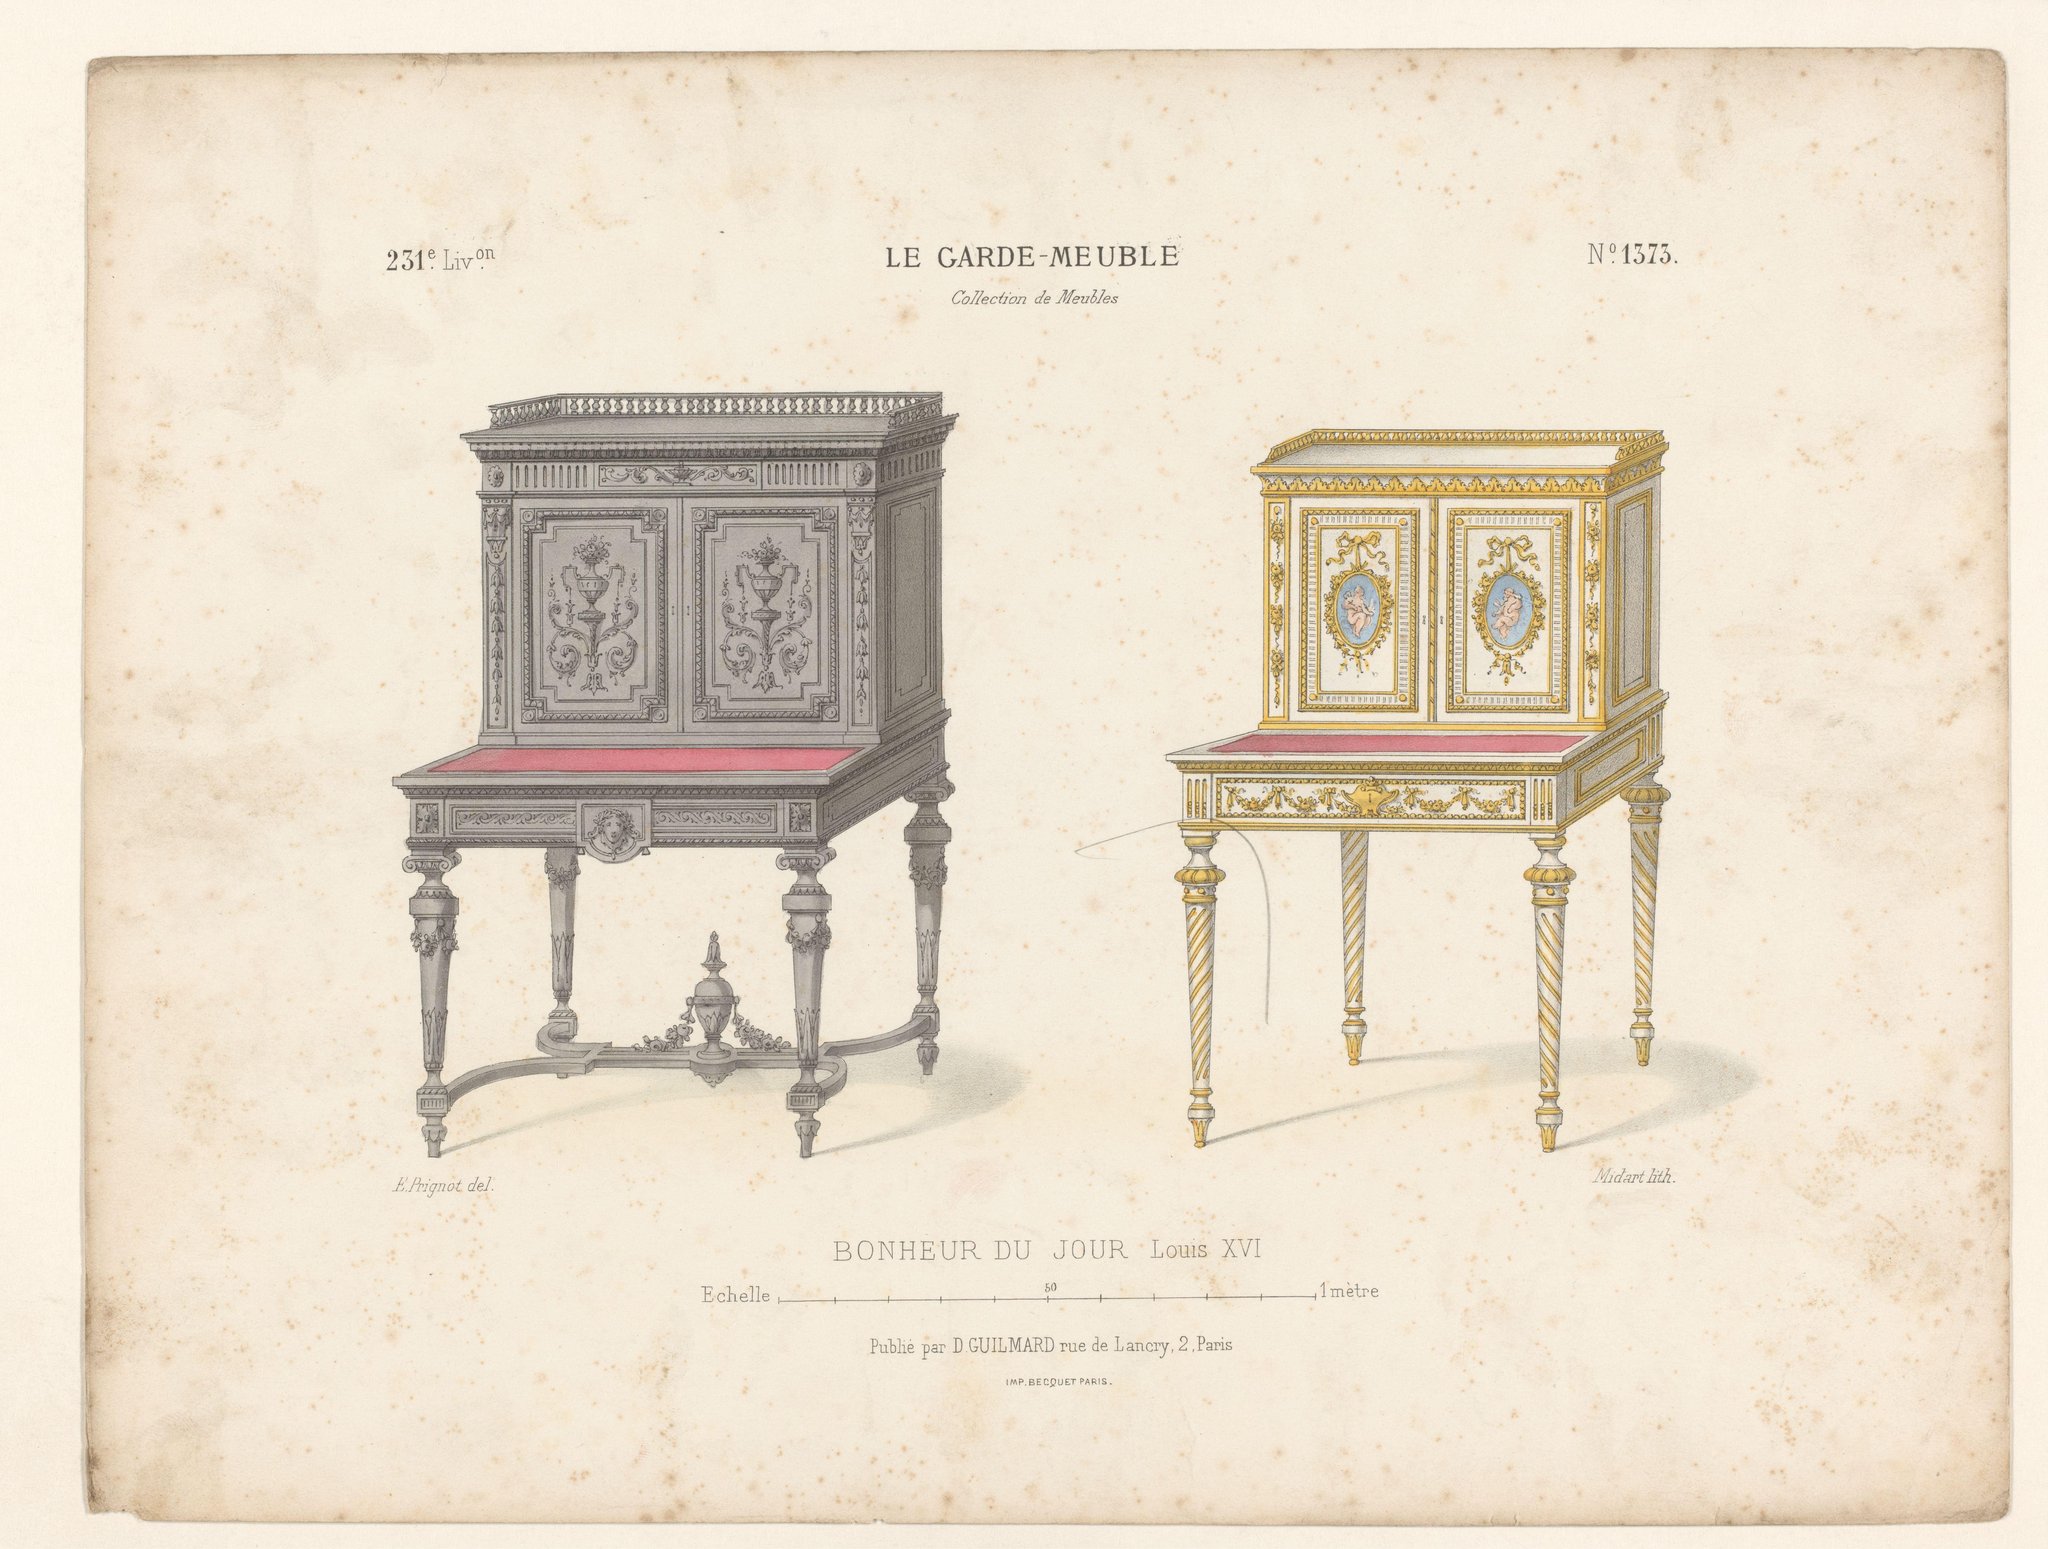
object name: print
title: Twee bonheurs du jour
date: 1839-1885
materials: paper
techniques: hand coloring, lithograph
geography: paris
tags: furniture for storage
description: Ieder Livraison in de serie Le Garde-Meuble bevat negen platen: drie 'sièges' (zitmeubels), drie 'meubles' (diverse meubels zoals tafels en kasten) en drie 'tentures' (gordijnen en draperieën).